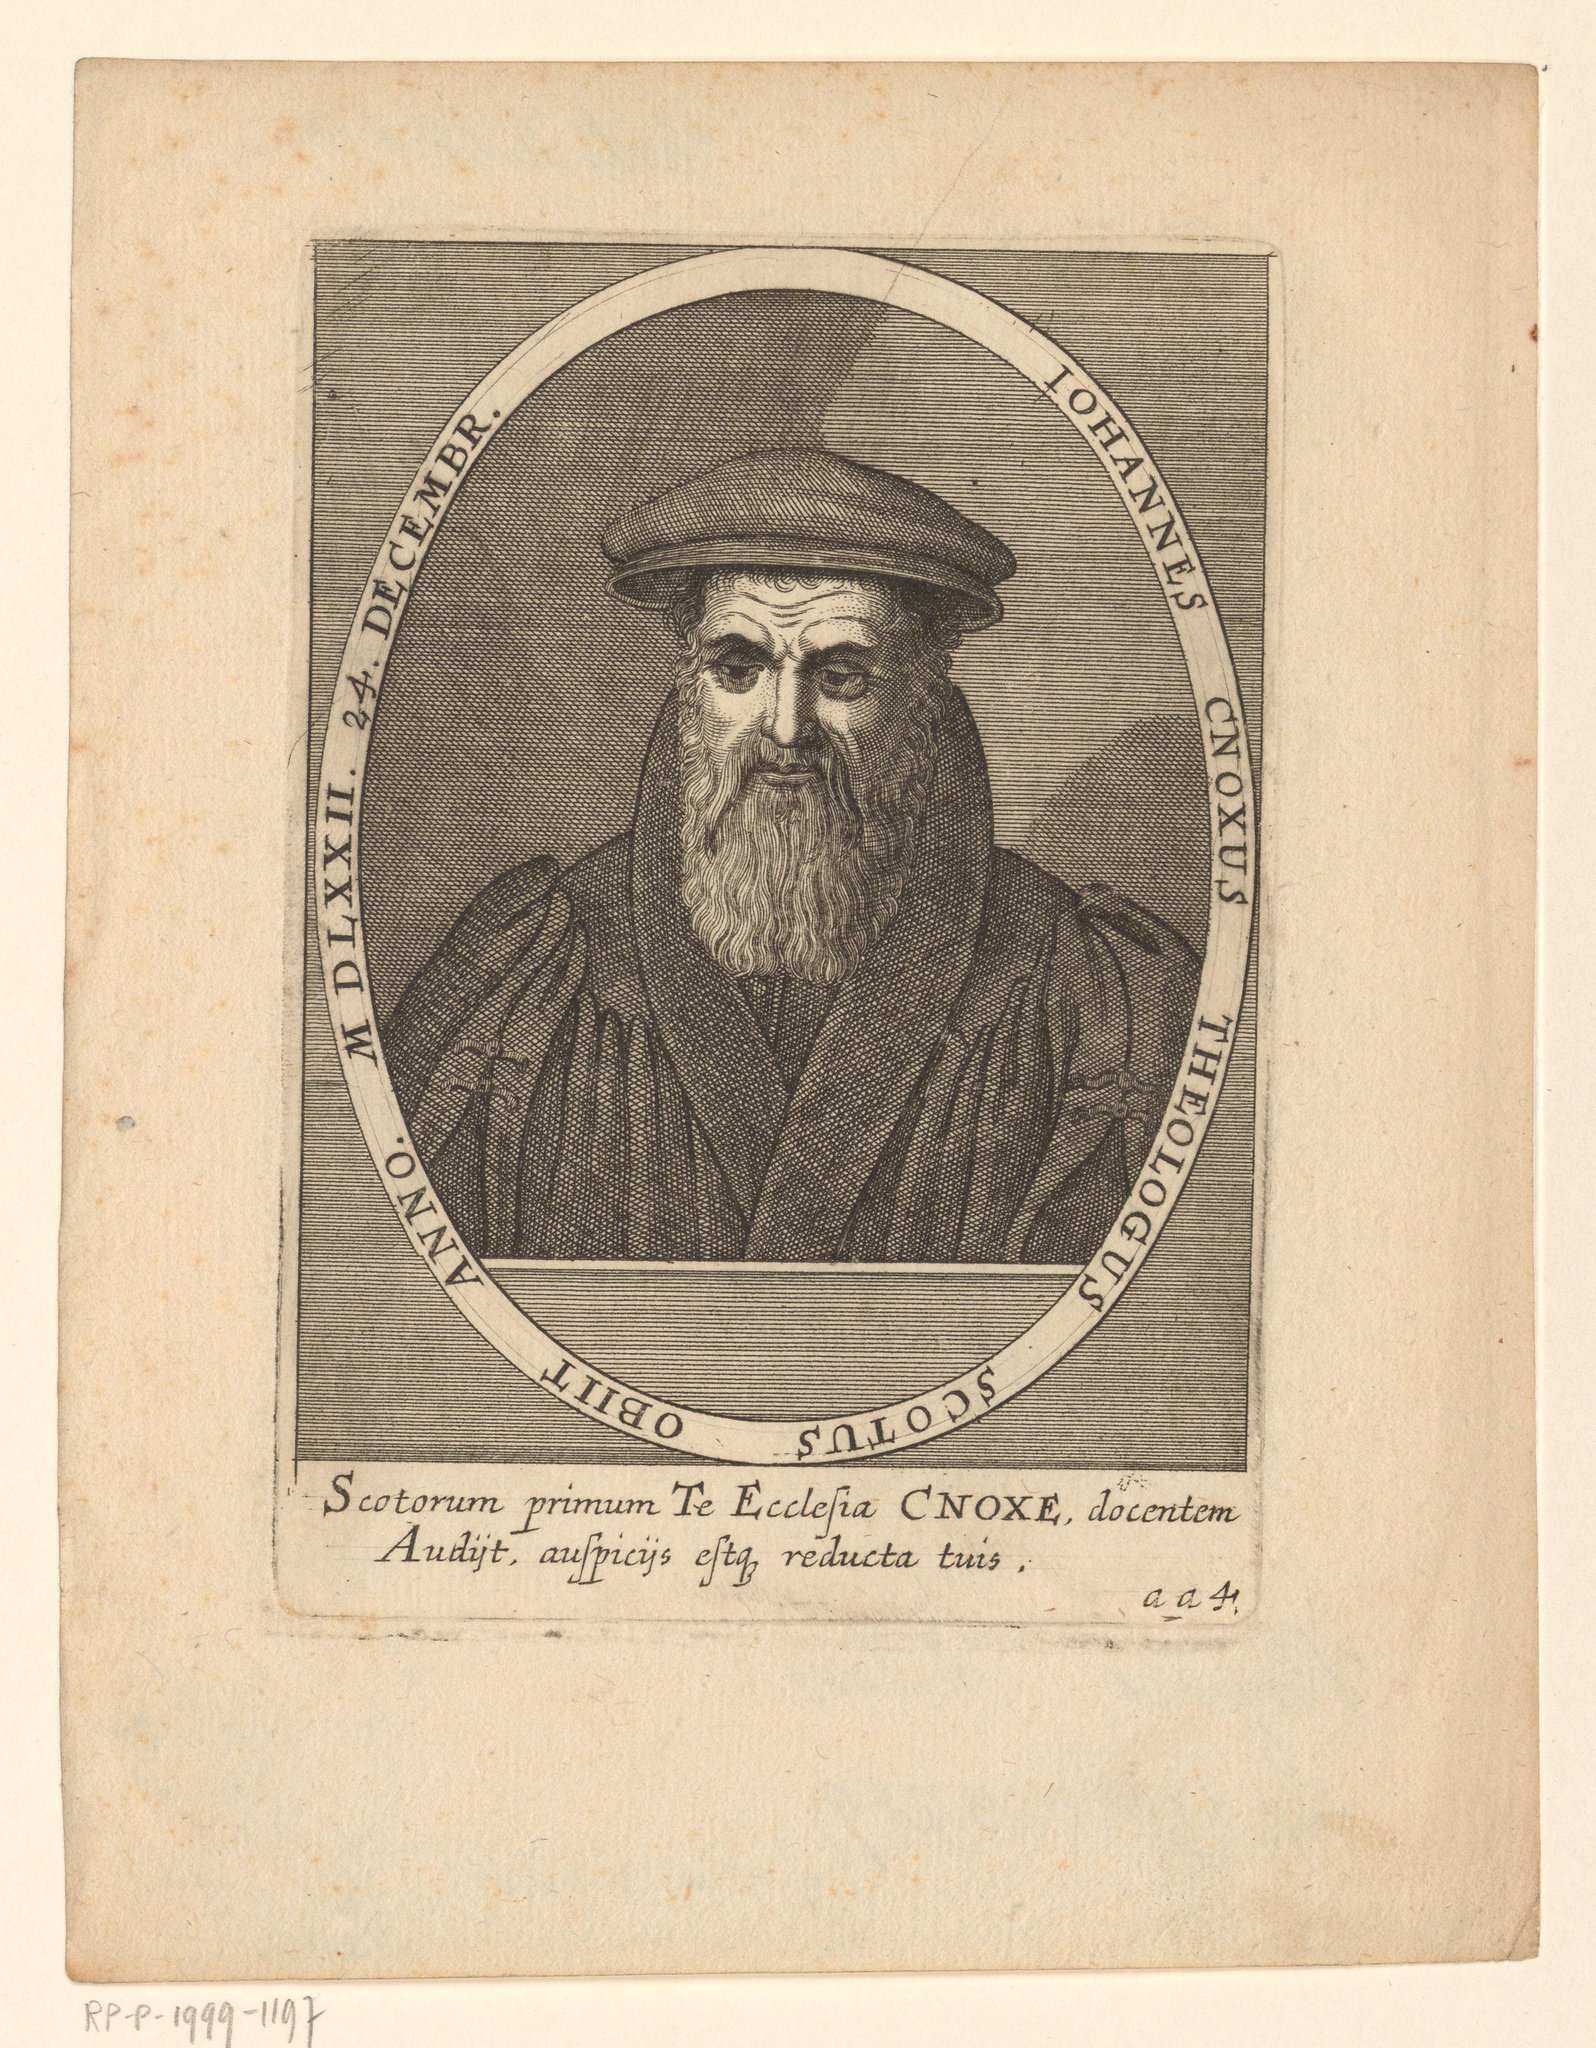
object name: book illustration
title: Portret van John Knox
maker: clemens ammon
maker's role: print maker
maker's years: 1627-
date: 1650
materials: paper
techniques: engraving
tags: historical persons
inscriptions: collector's mark: Lugt 2760, collector's mark: Lugt 2228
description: Prent uit: Bibliotheca chalcographica. Frankfurt am Main: Johannes Ammon, 1650. Prent voor het eerst (zonder nummering) verschenen in: Boissard, Jean Jacques. Icones quinquaginta virorum illustrium doctrina & eruditione praestantium ad vivum effictae. Frankfurt am Main: s.n., 1597.